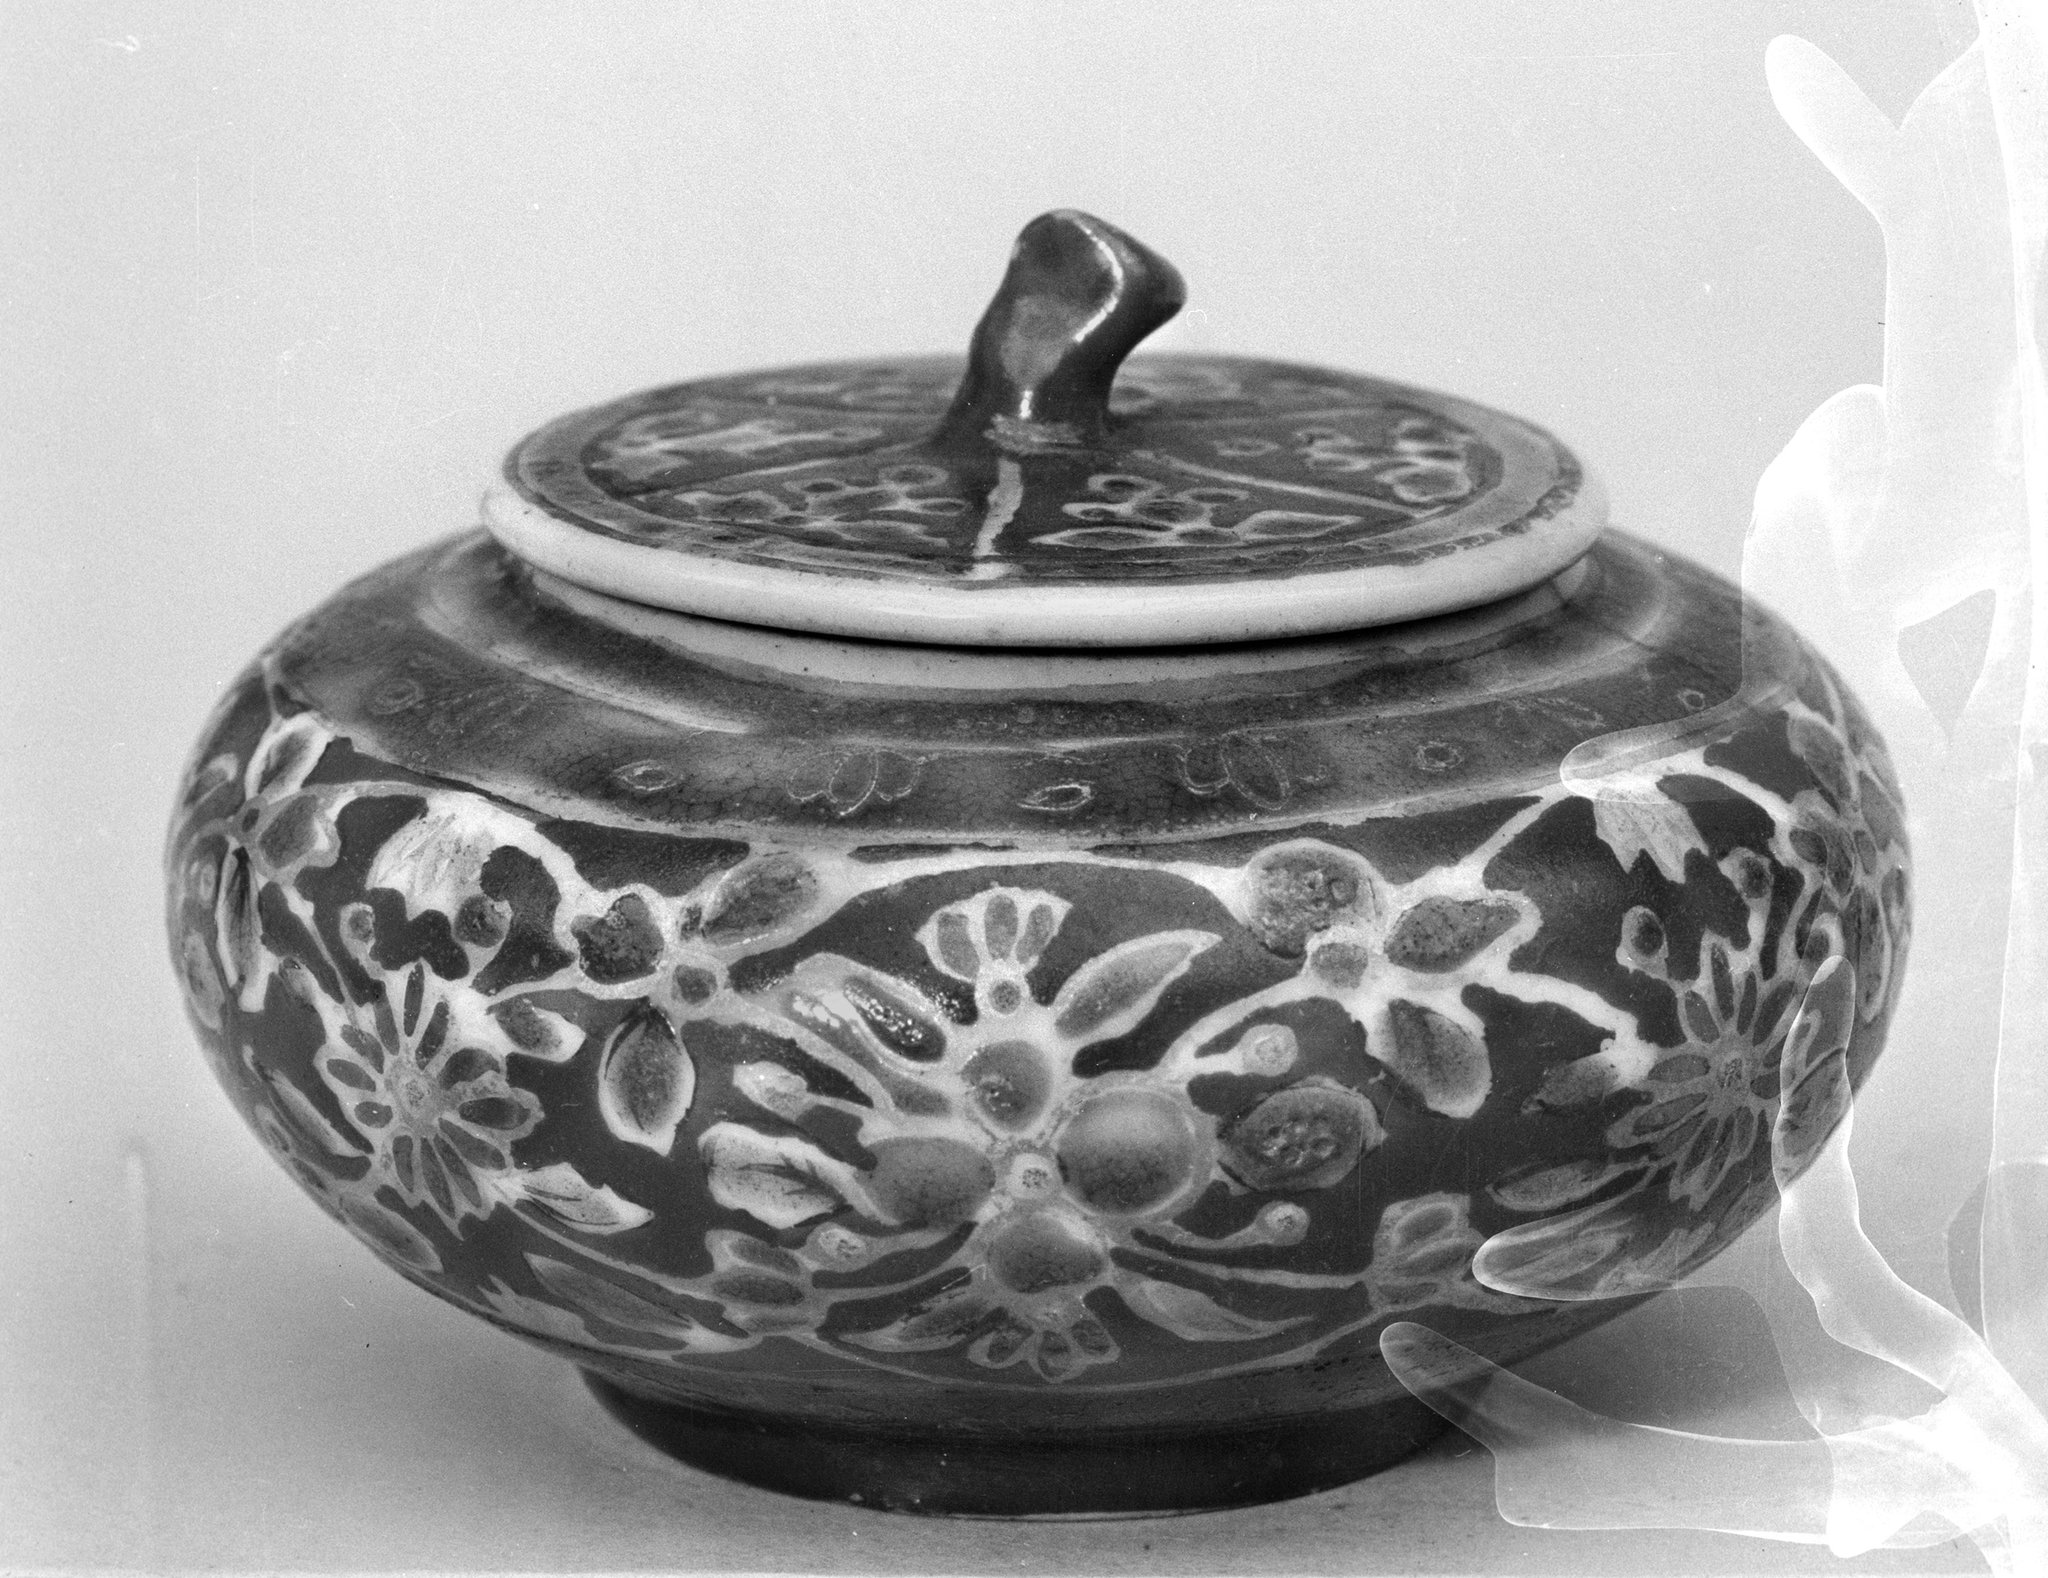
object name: covered jar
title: Covered jar with floral pattern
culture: chinese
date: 1801-1900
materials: enamel, porcelain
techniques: overglaze, painting, polychrome